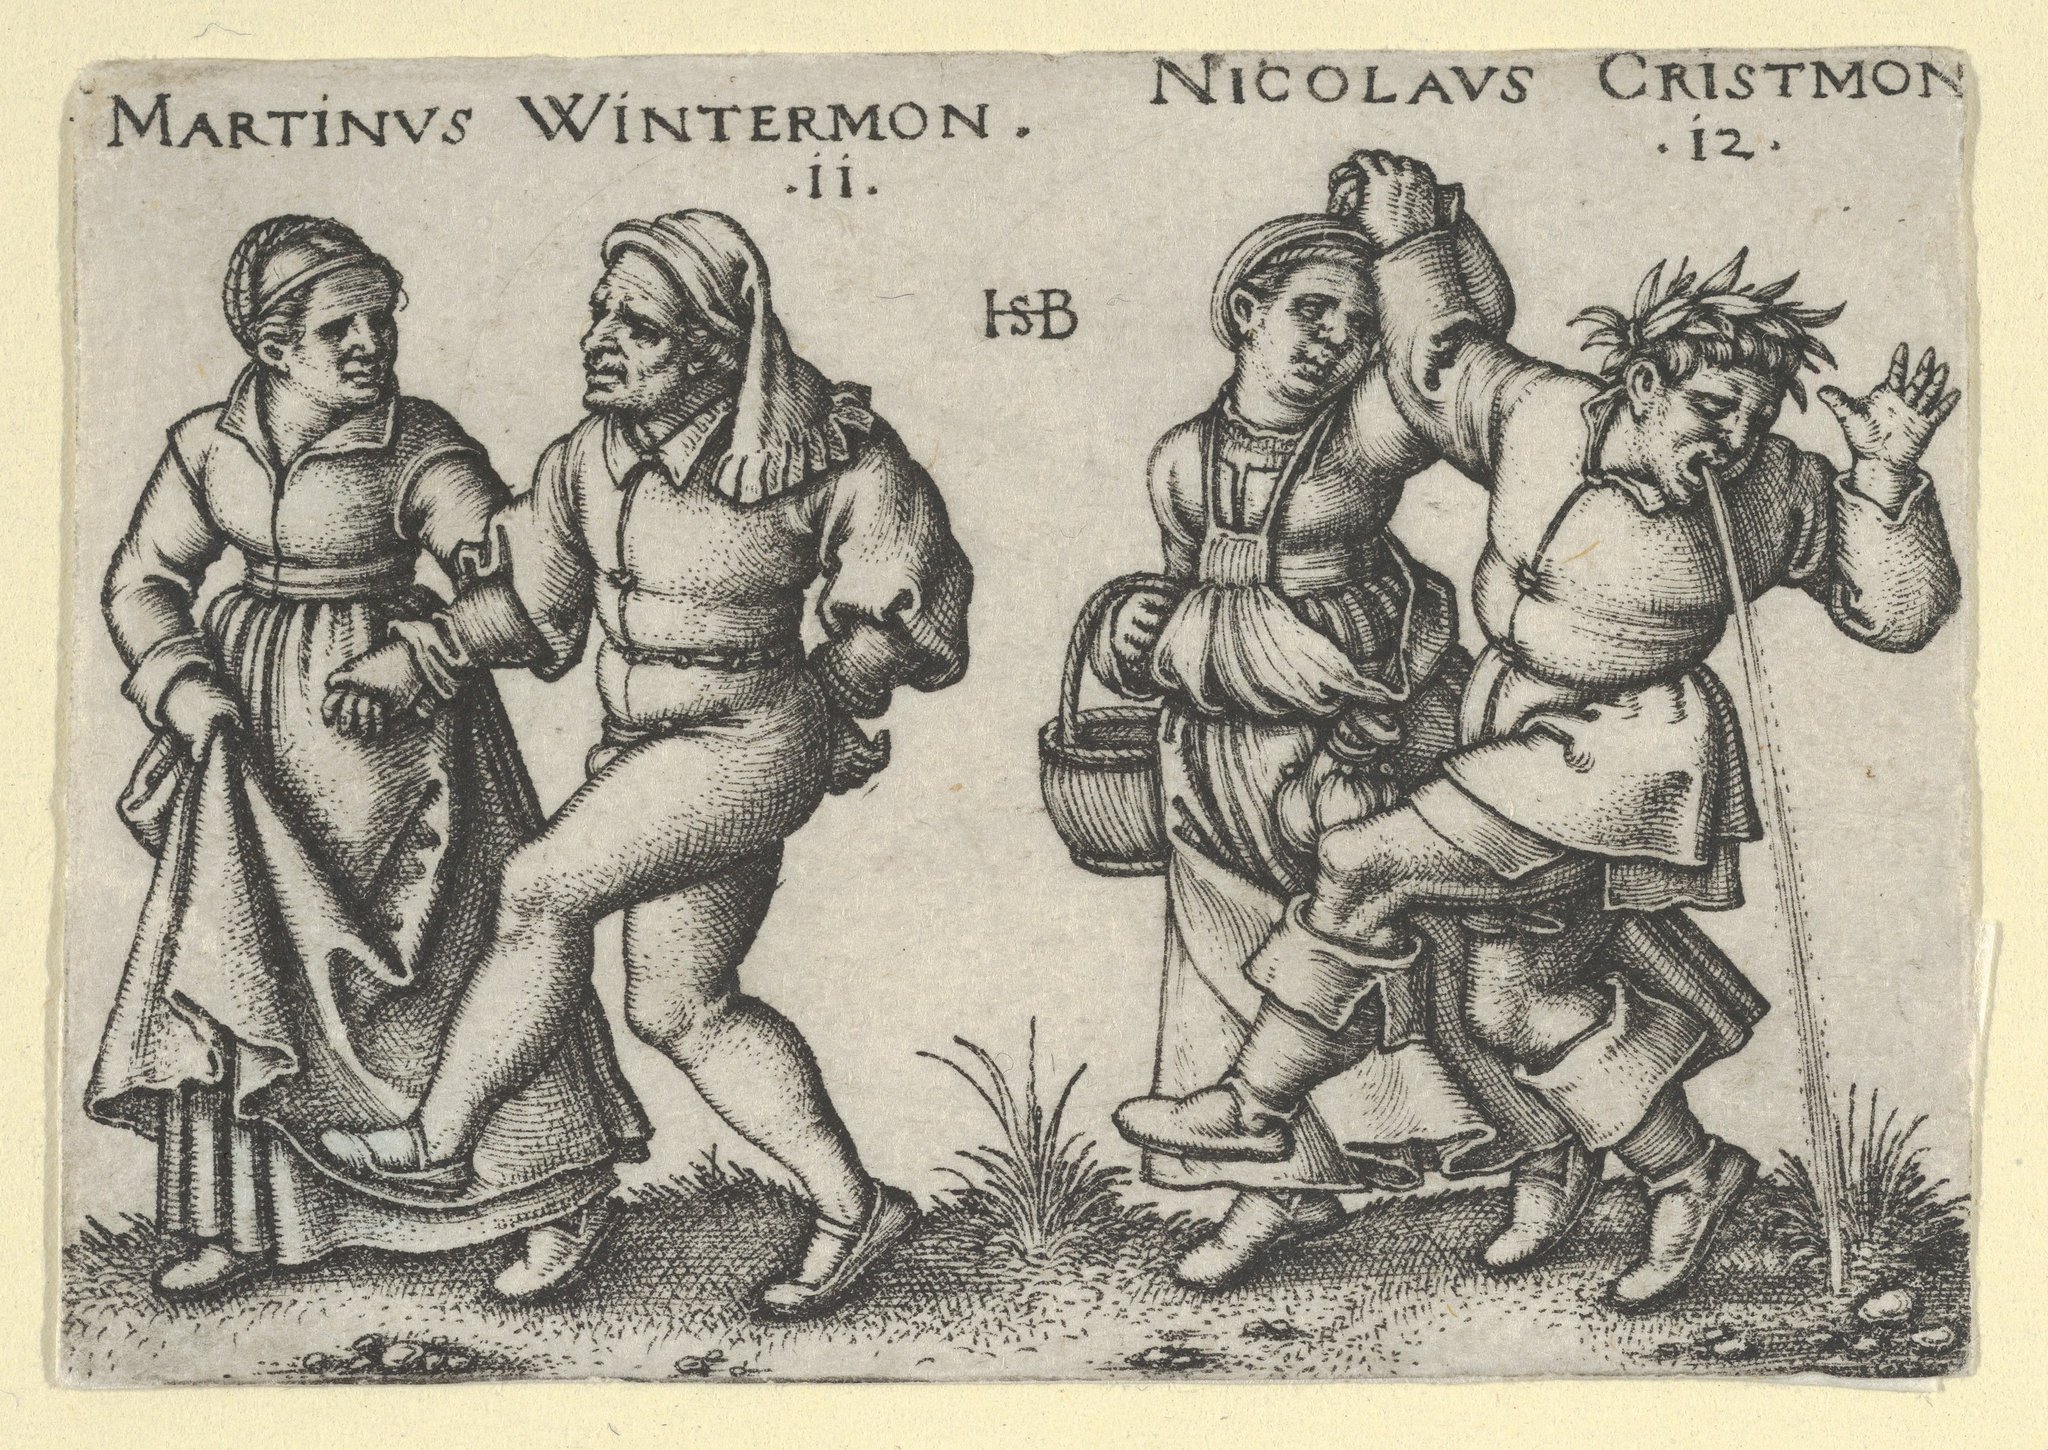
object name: print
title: November and December from "The Peasants' Feast" or "The Twelve Months"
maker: sebald beham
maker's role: artist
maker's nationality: german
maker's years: 1500-1550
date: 1546-1547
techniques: engraving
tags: couples,men,women,dancing